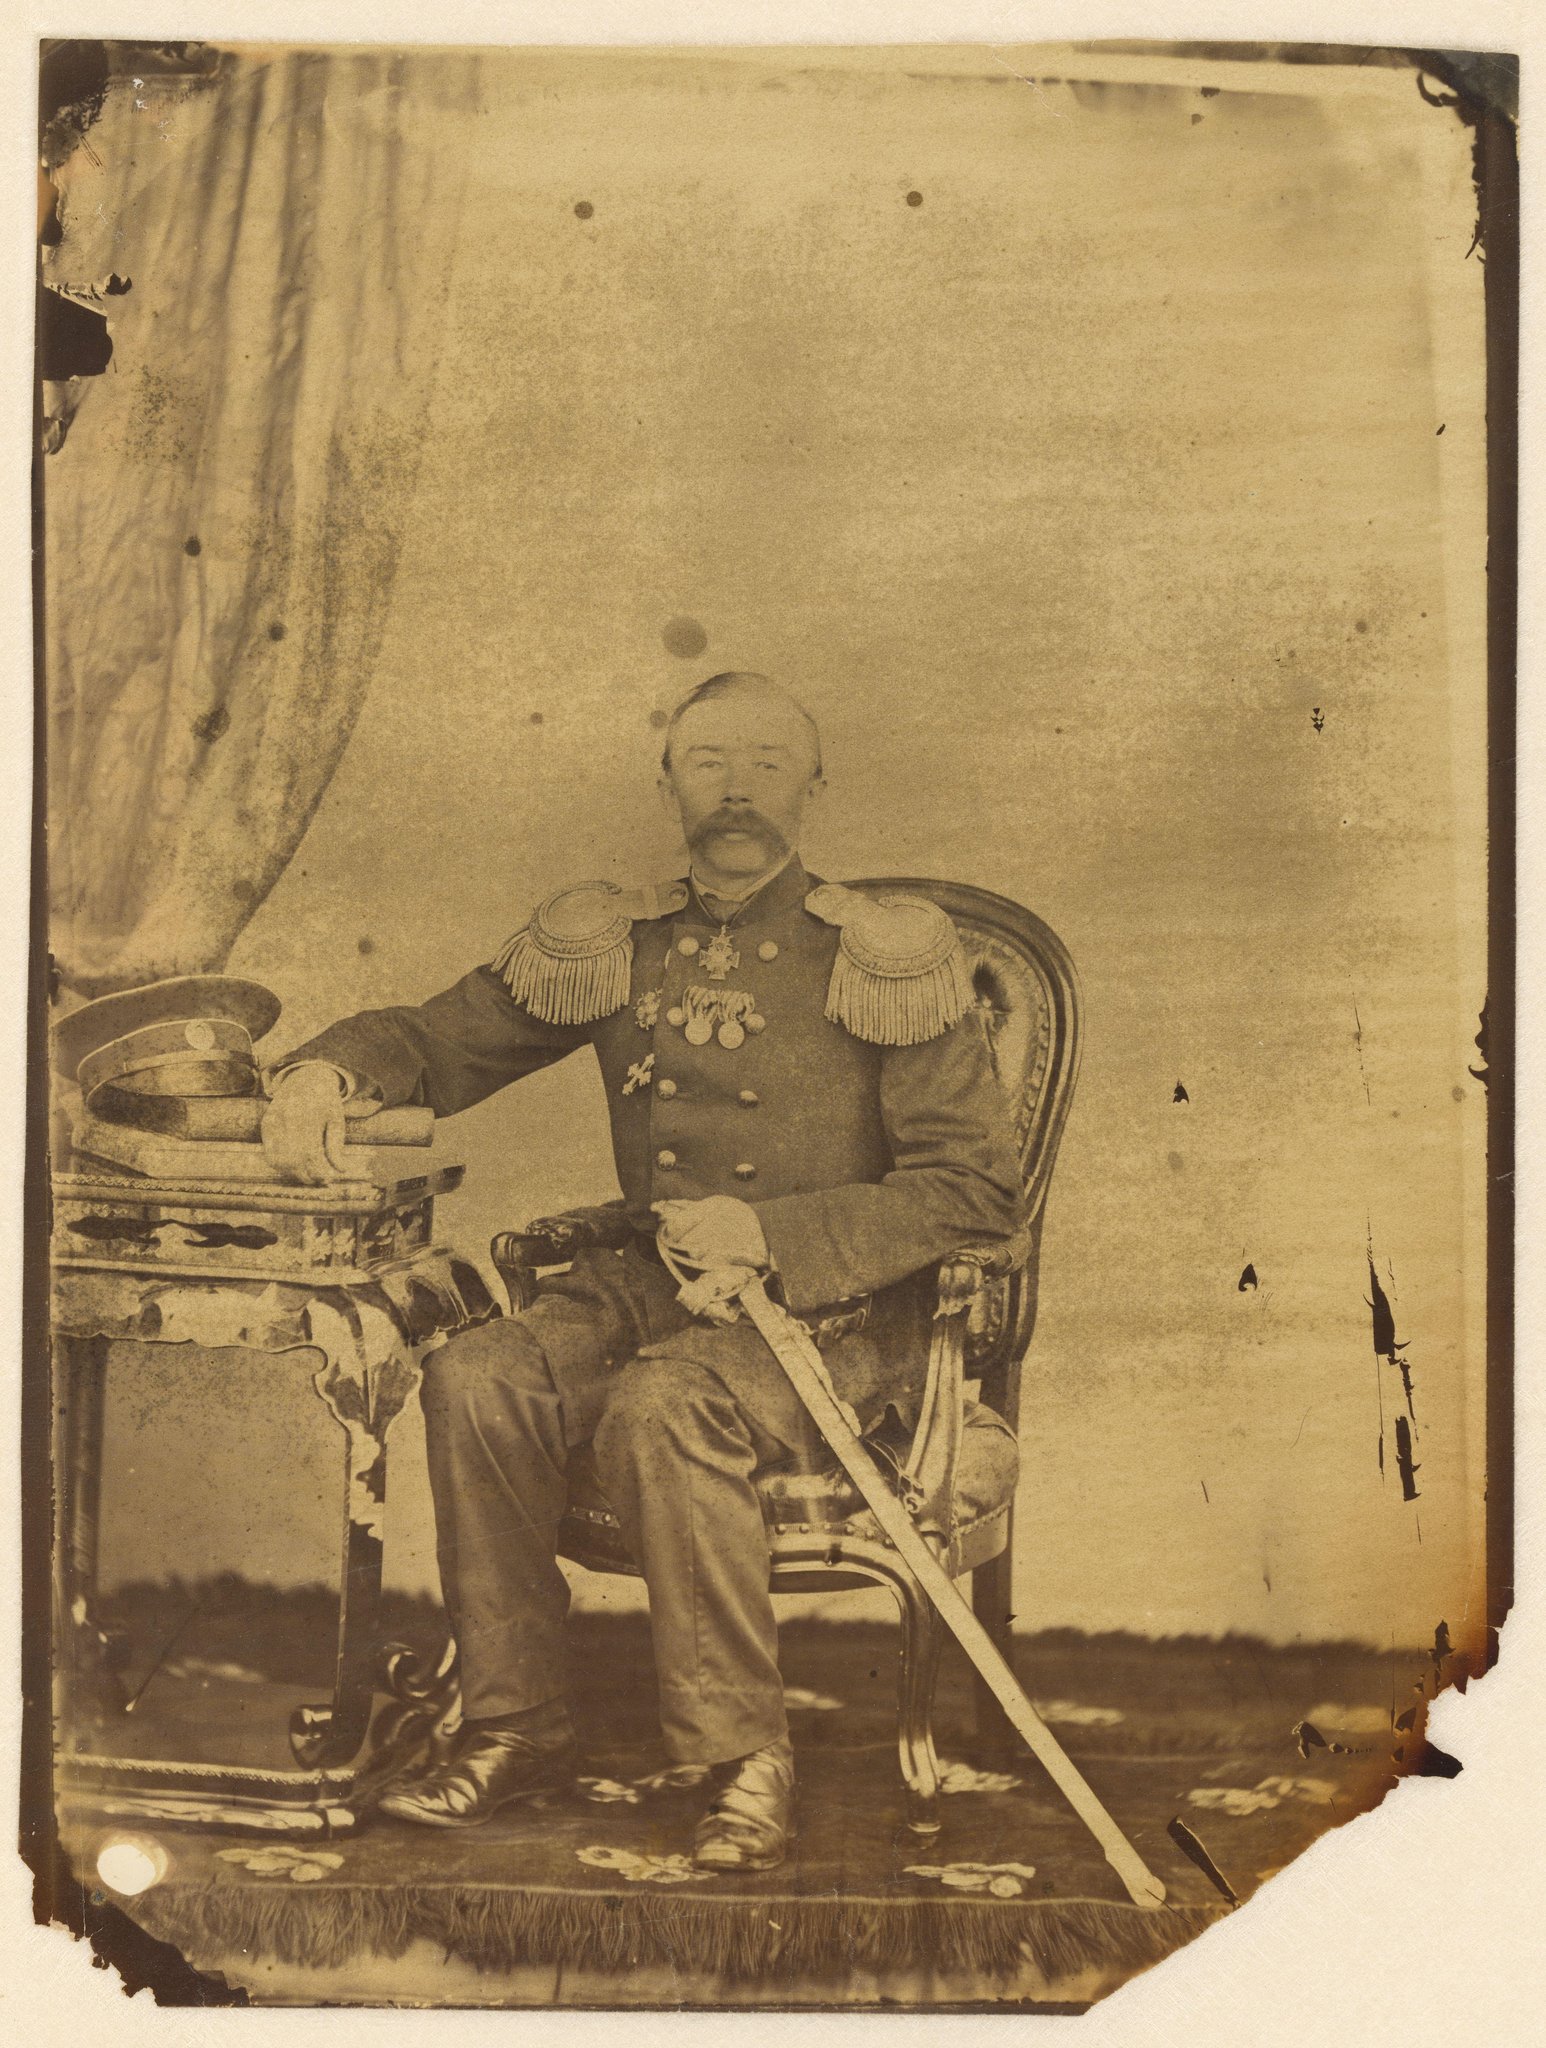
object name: photograph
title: Portret van een onbekende militair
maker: antoon bauduin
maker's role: amateurfotograaf, hoogleraar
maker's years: 1820-1885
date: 1862-1866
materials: paper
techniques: albumen print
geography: japan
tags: historical persons not known by name, japan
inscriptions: number: ‘33’